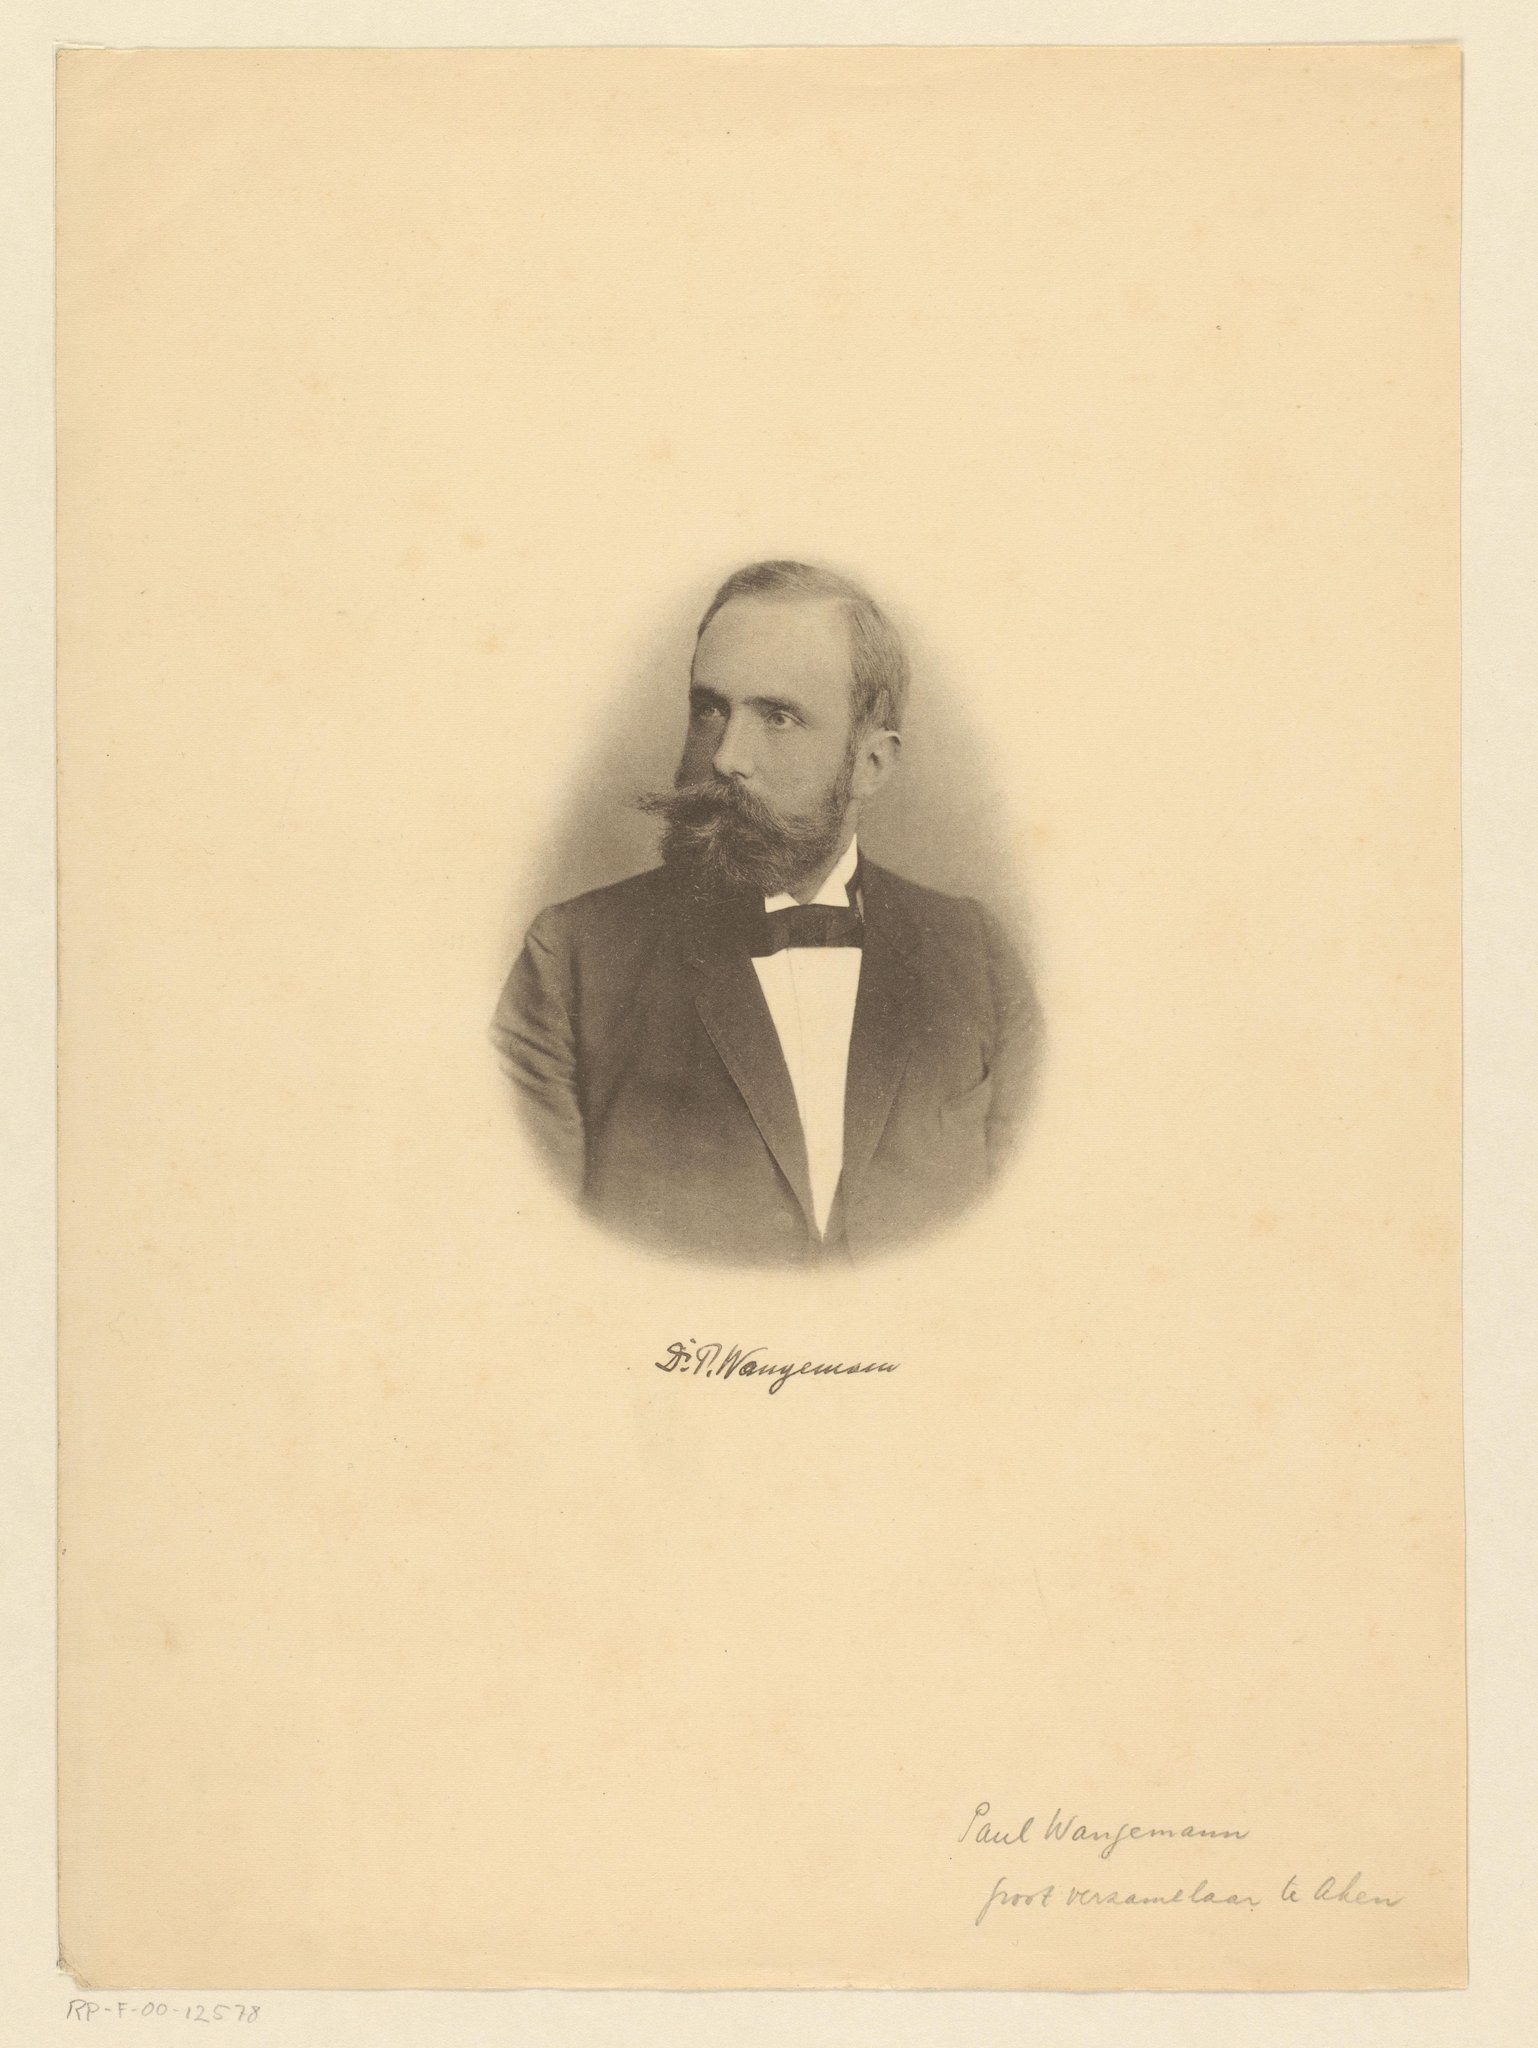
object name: photomechanical print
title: Portret van Paul Wangemann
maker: Anonymous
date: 1870-1930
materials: paper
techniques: photograph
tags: historical persons